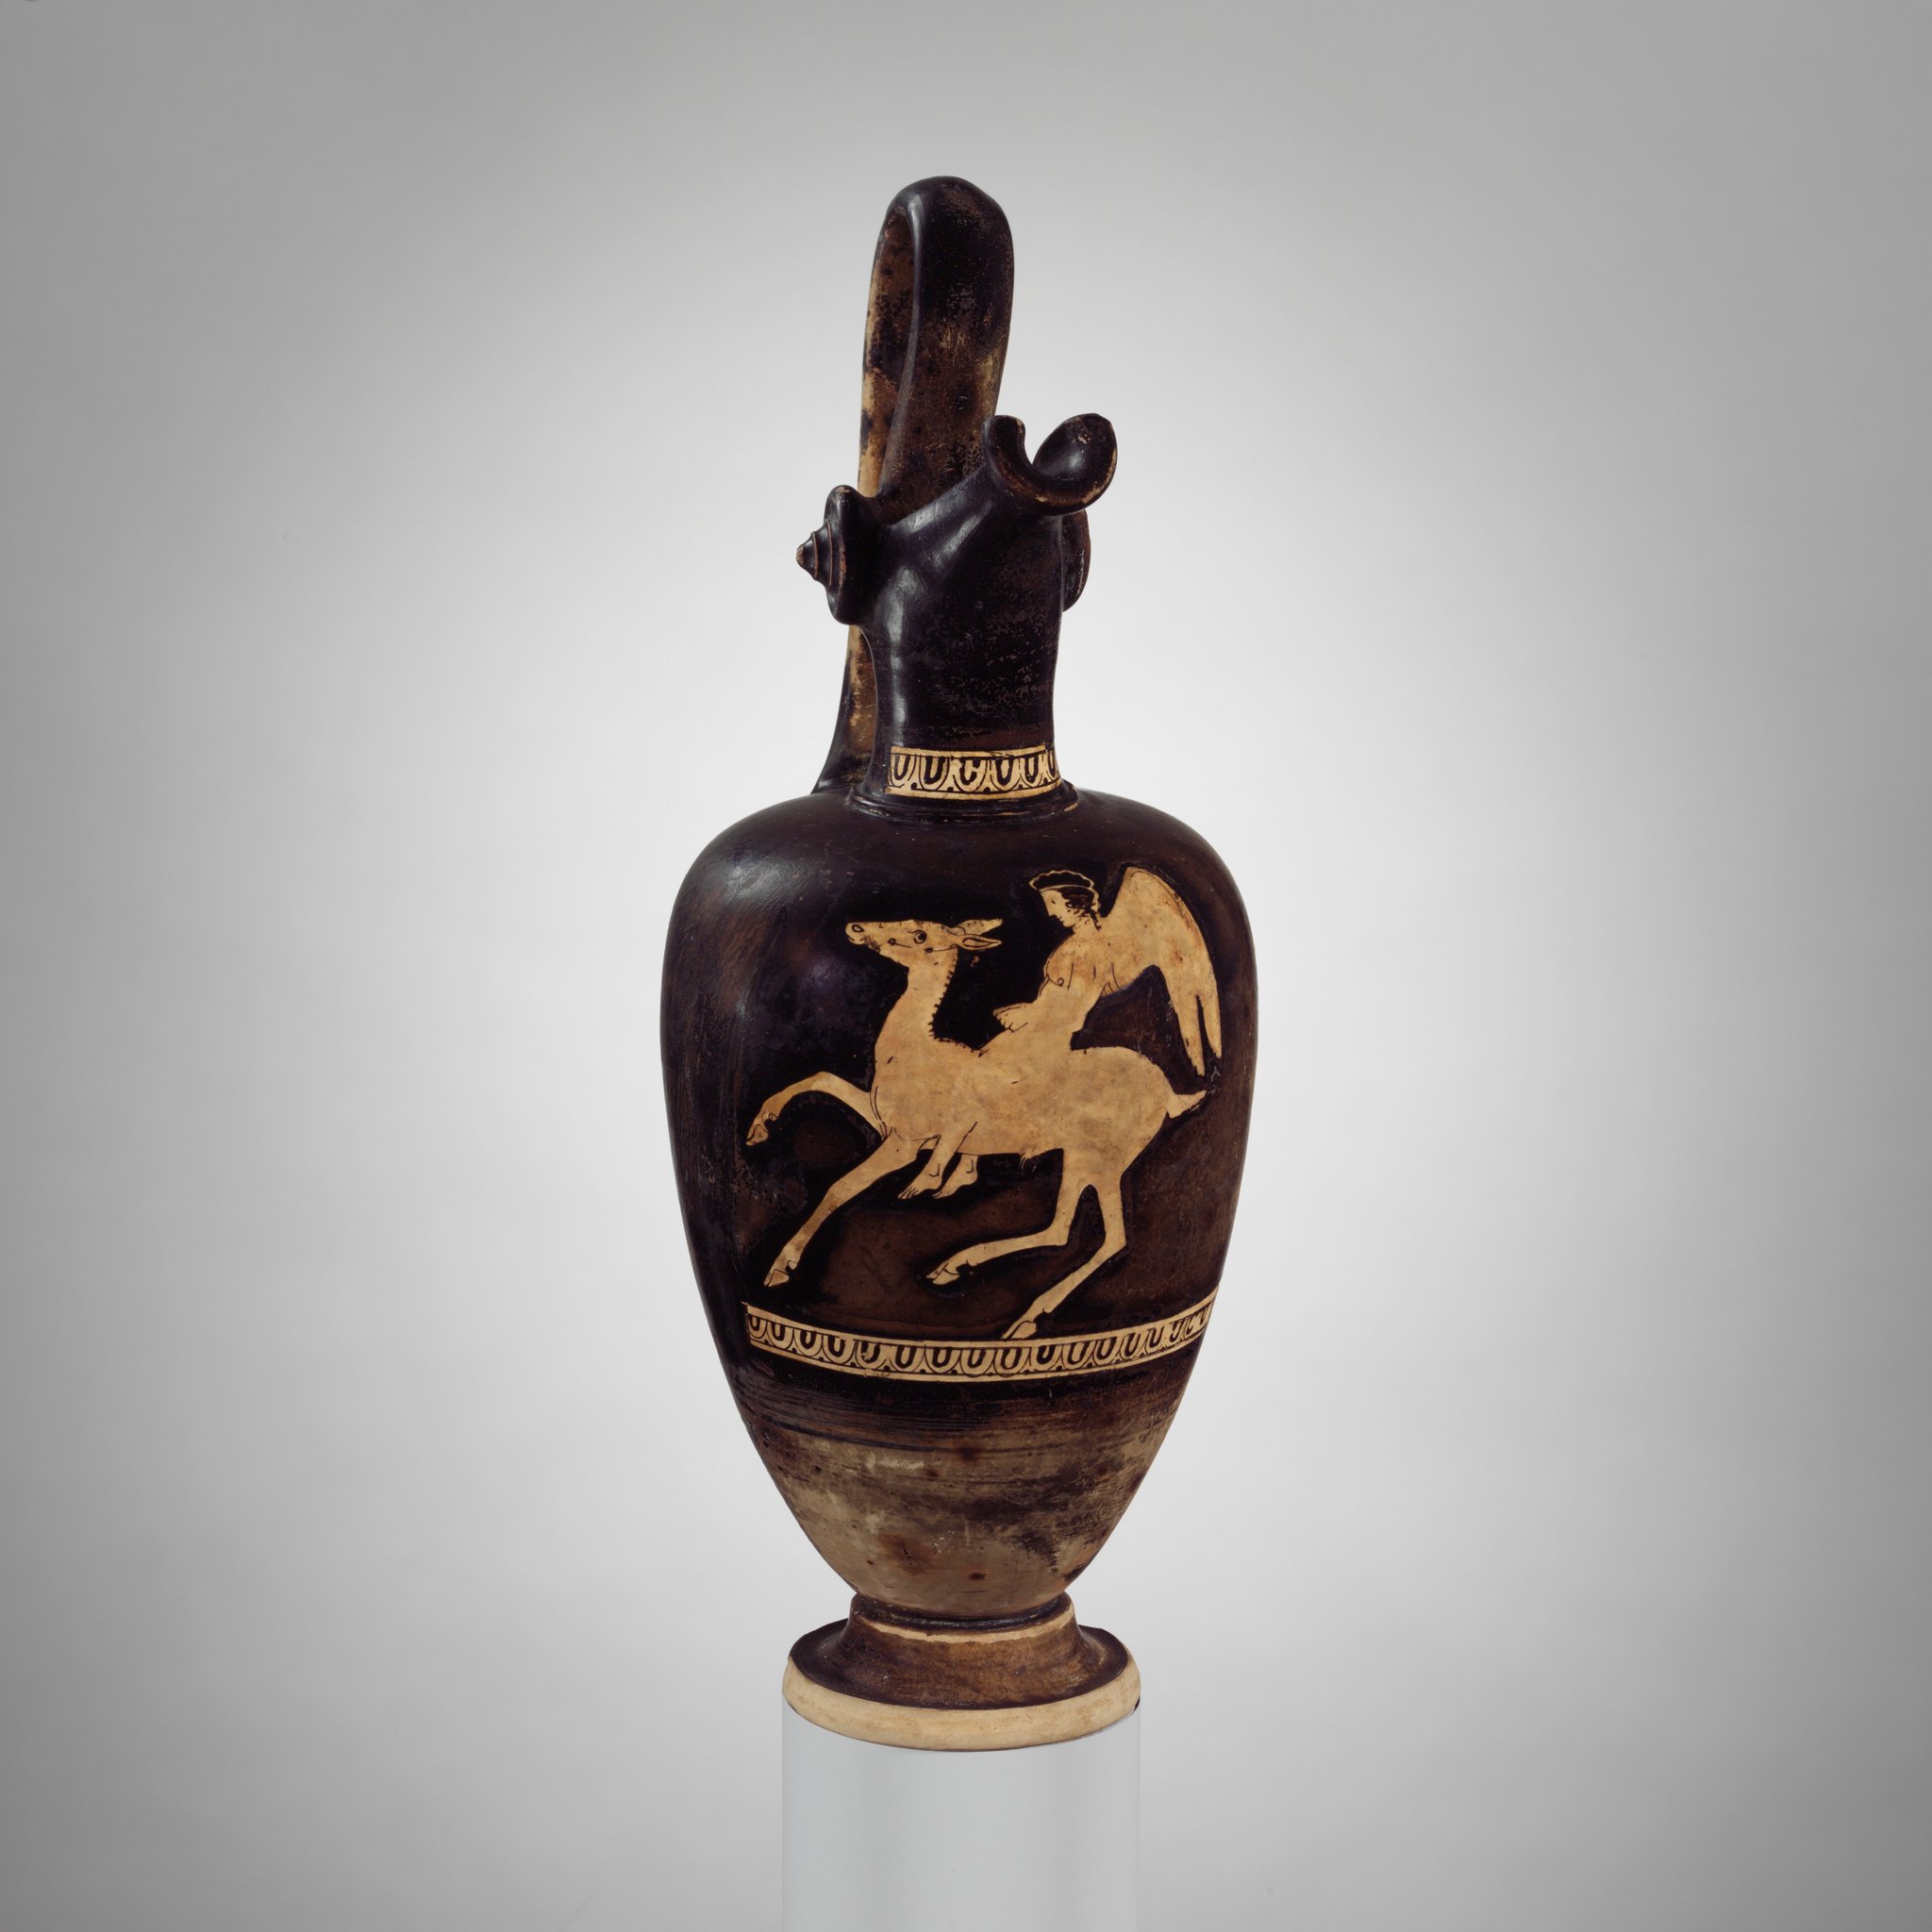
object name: oinochoe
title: Terracotta oinochoe (jug)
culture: greek, attic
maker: polion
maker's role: artist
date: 420 BCE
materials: terracotta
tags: eros,deer